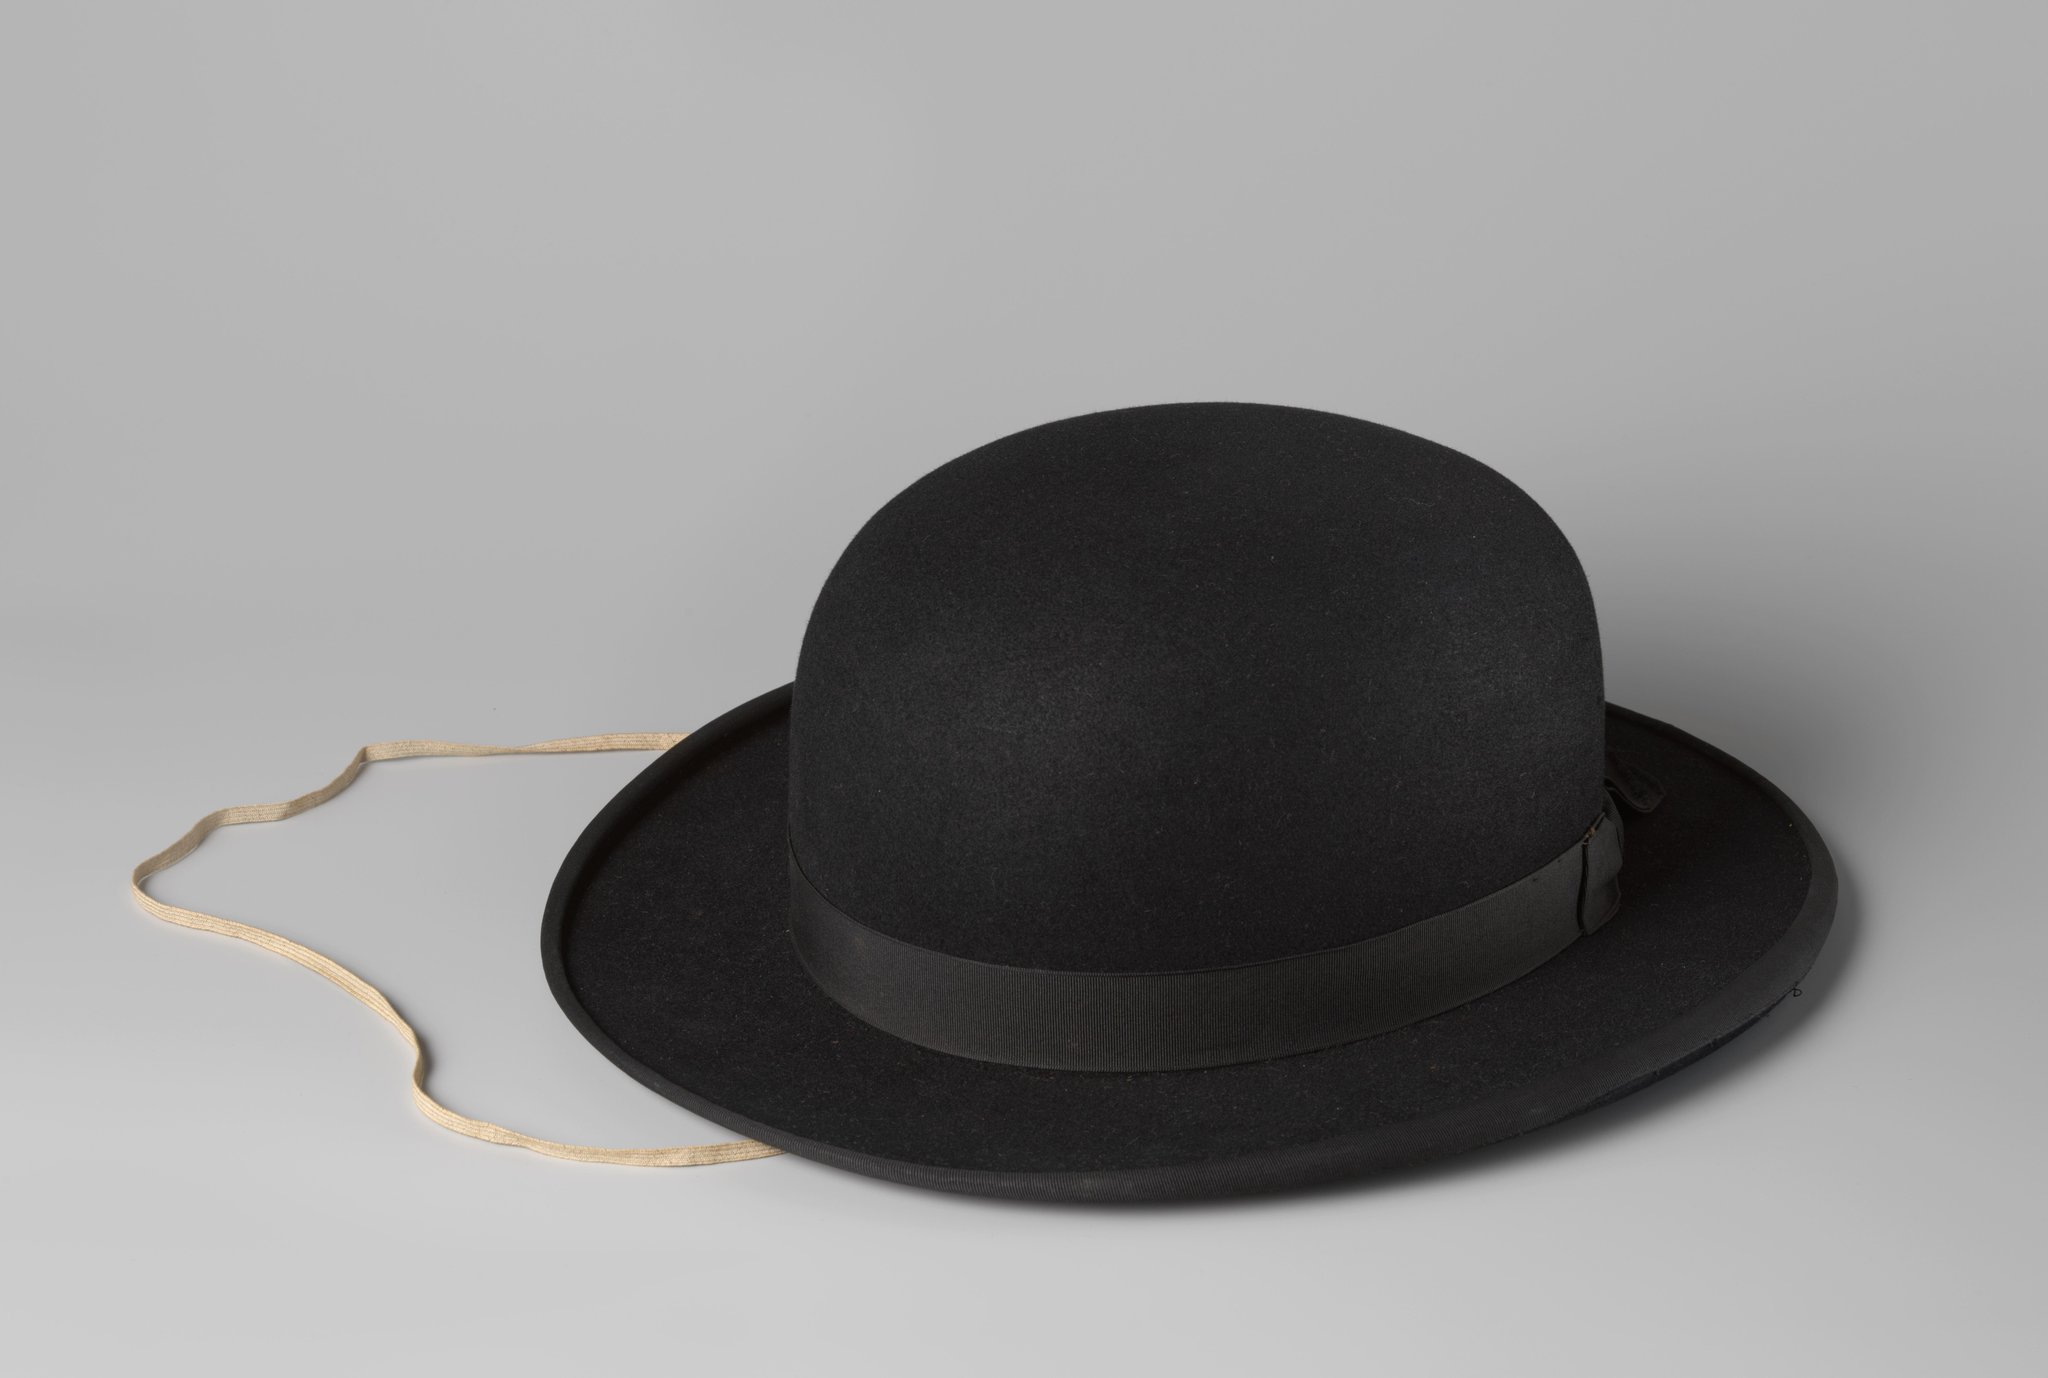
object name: clothing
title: Amazonehoed van zwart vilt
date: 1890-1900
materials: felt, leather, silk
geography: the hague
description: Amazonehoed van zwart vilt. Stijve dophoed, vrij plat en enigszins ovaal. Van binnen een creme leren hoofdband en een wit zijden capaline met adres: Frans Pauwels/HOFLEVERANCIERS/'S-GRAVENHAGE.